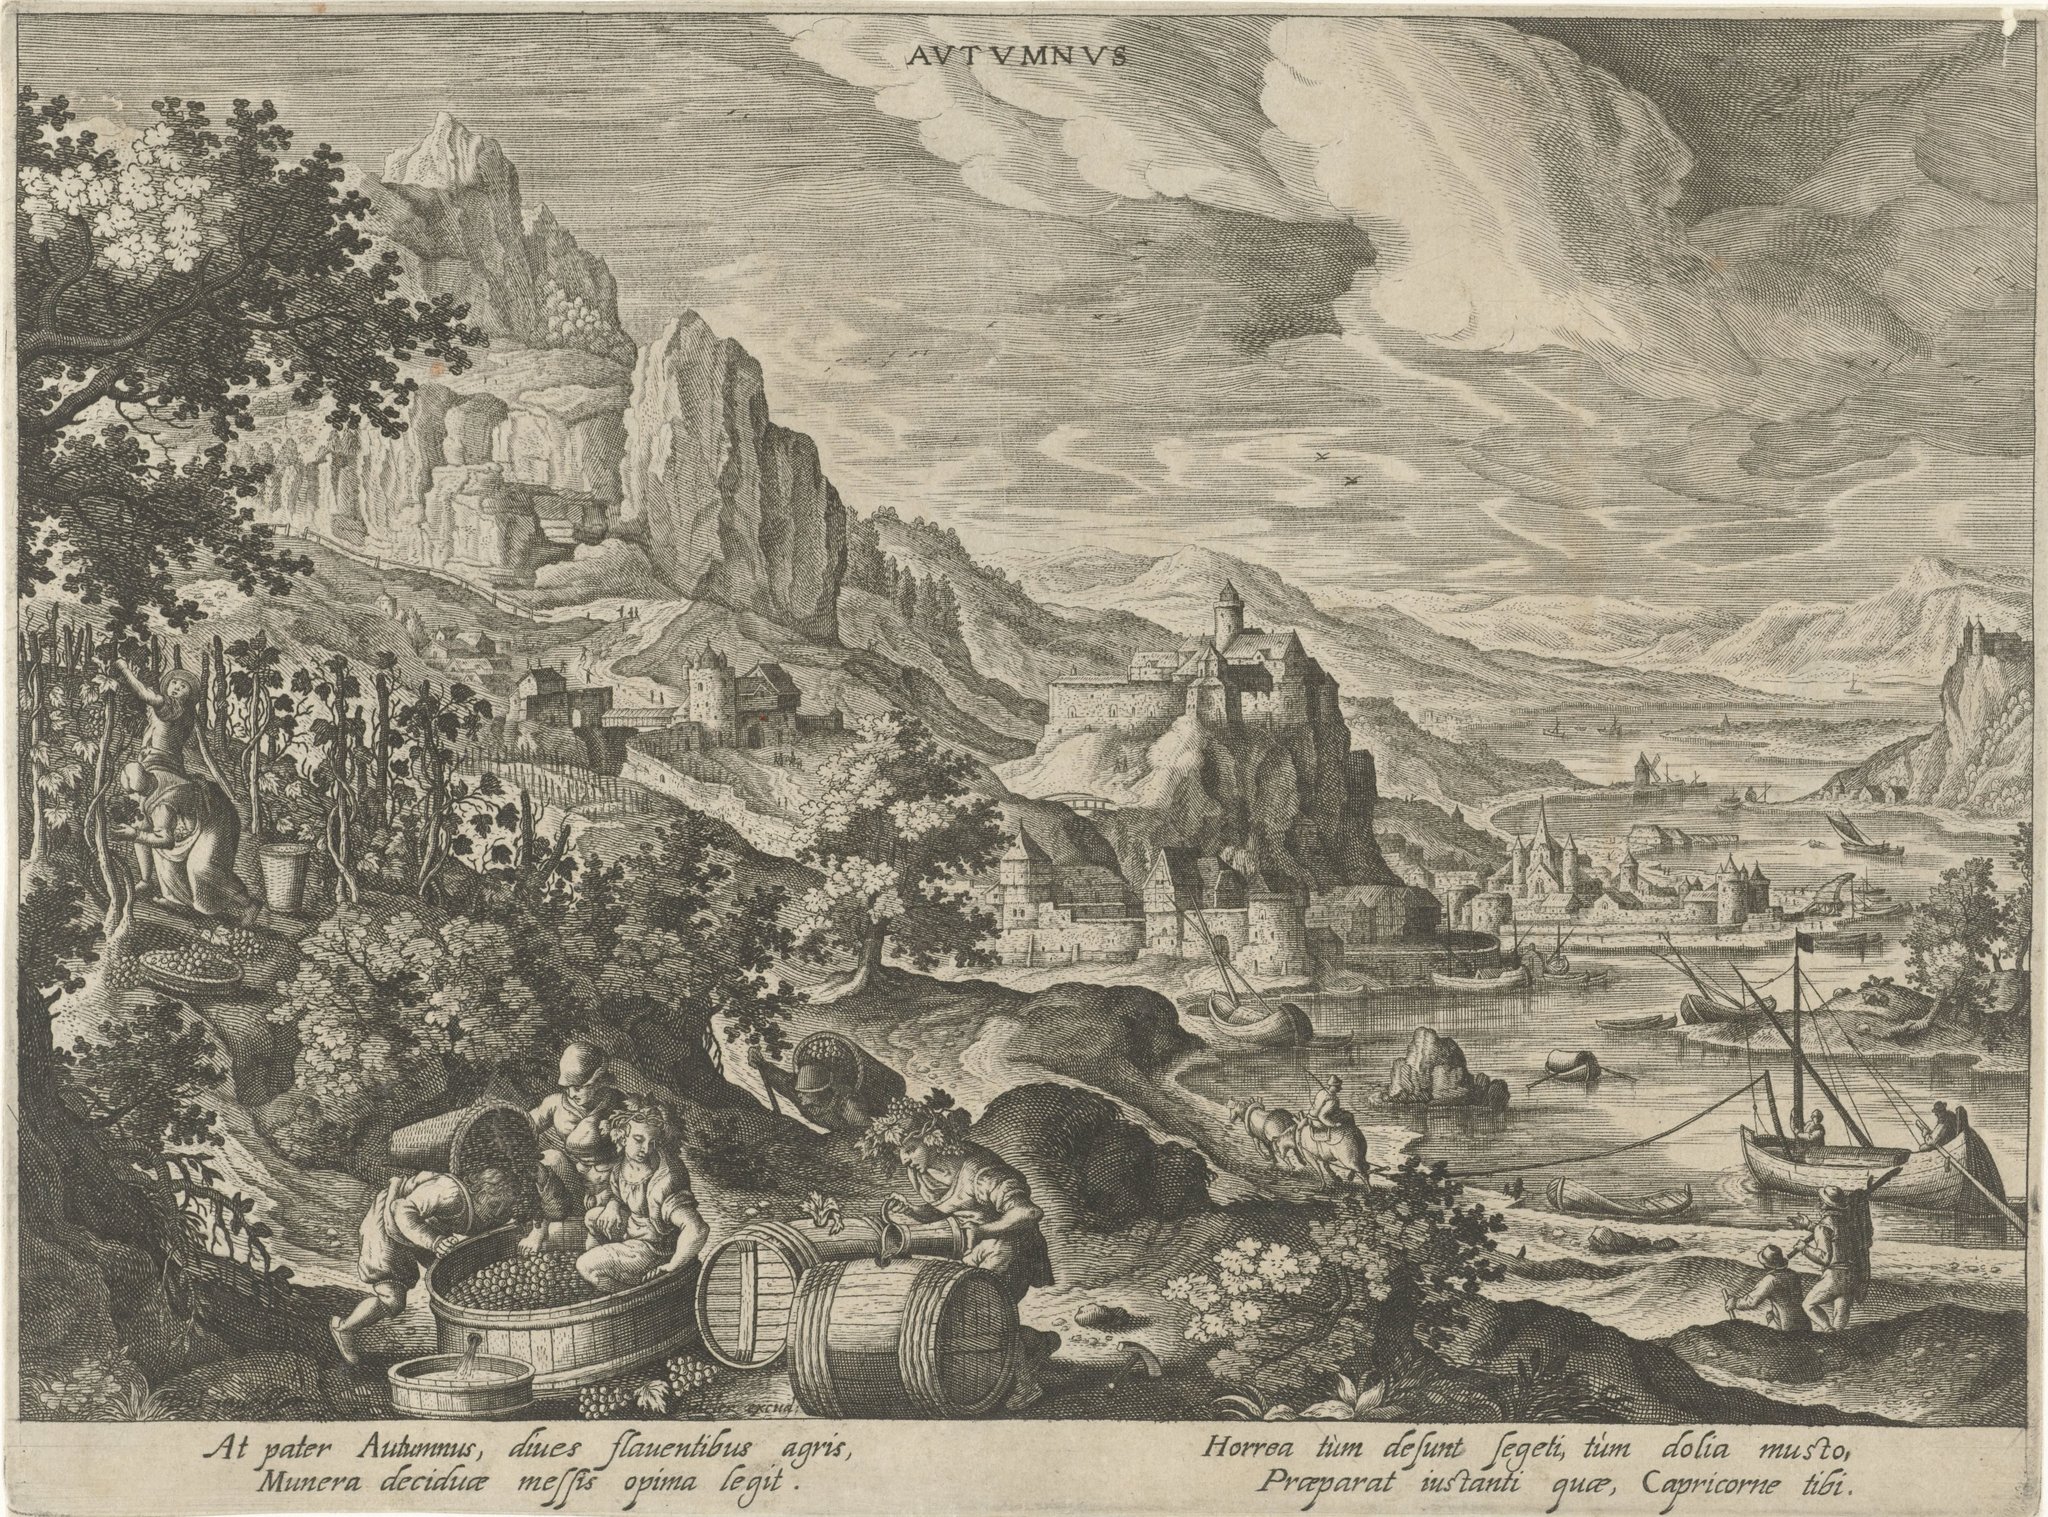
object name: print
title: Autumnus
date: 1595-1622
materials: paper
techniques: engraving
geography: rome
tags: autumn ~ human activities (the four seasons of the year), boat propelled by man or animal, viticulture, wine-growing; vintage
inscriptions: collector's mark: Lugt 2228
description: Gezicht op een bergachtig landschap, door een rivier doorsneden. Op de voorgrond een wijngaard waar druiven worden geplukt en een man een mand met druiven in een grote kuip stort. In de kuip zijn een man en een vrouw bezig om de druiven uit te persen. Naast de kuip giet een man wijn uit een kan in een wijnvat. Op de rivier diverse schepen, waarvan er een door twee paarden wordt voortgetrokken. De prent is deel van een serie van vier prenten met de vier seizoenen.